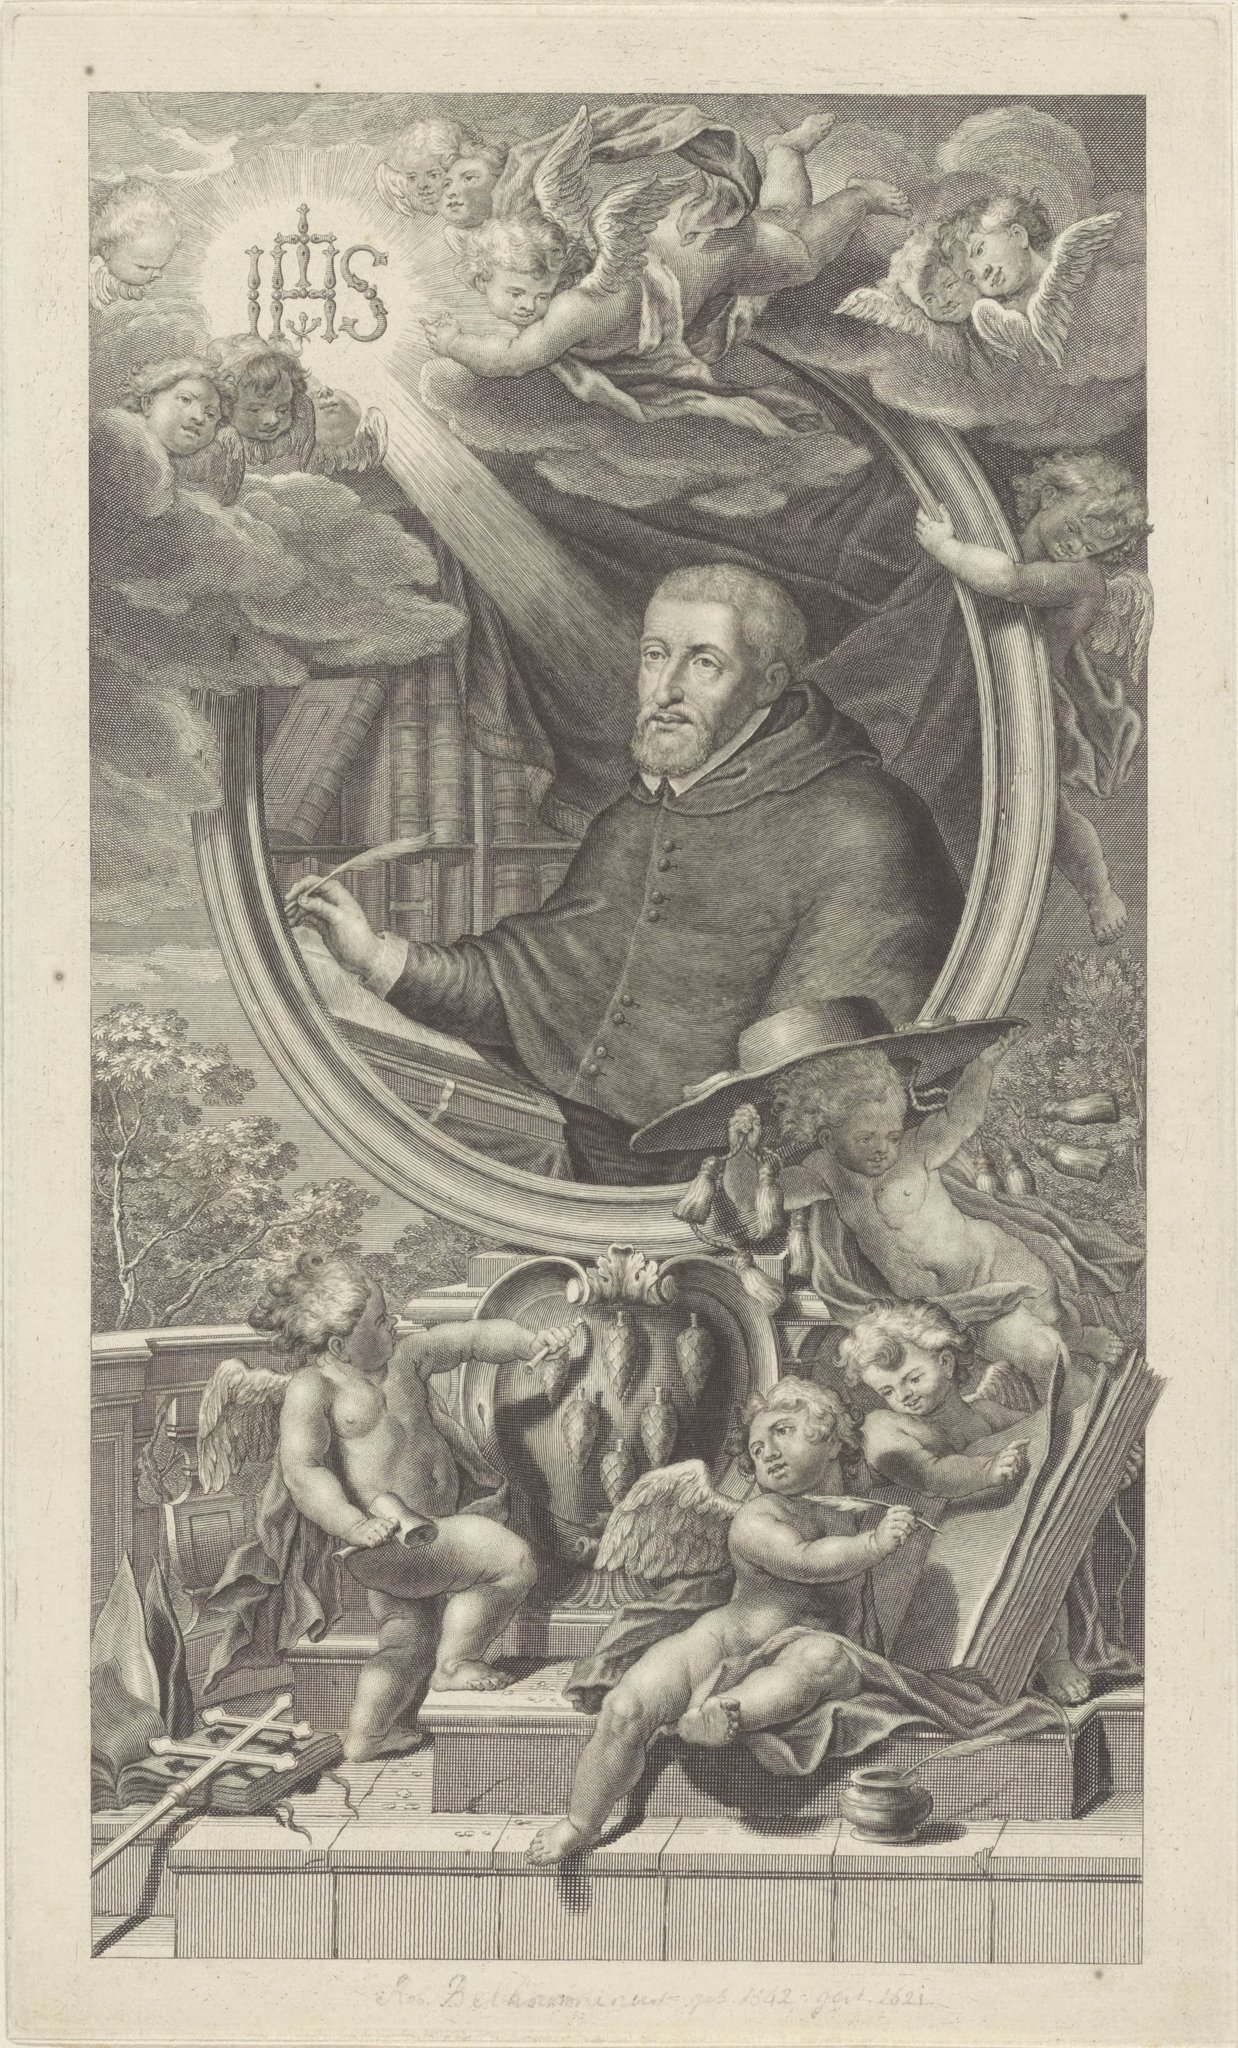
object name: print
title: Portret van een kardinaal omringt door putti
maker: johann friedrich greuter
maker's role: print maker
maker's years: 1589-1662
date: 1599-1662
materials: paper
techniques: engraving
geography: italy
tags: historical persons, cupids: 'amores', 'amoretti', 'putti'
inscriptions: collector's mark: Lugt 2228